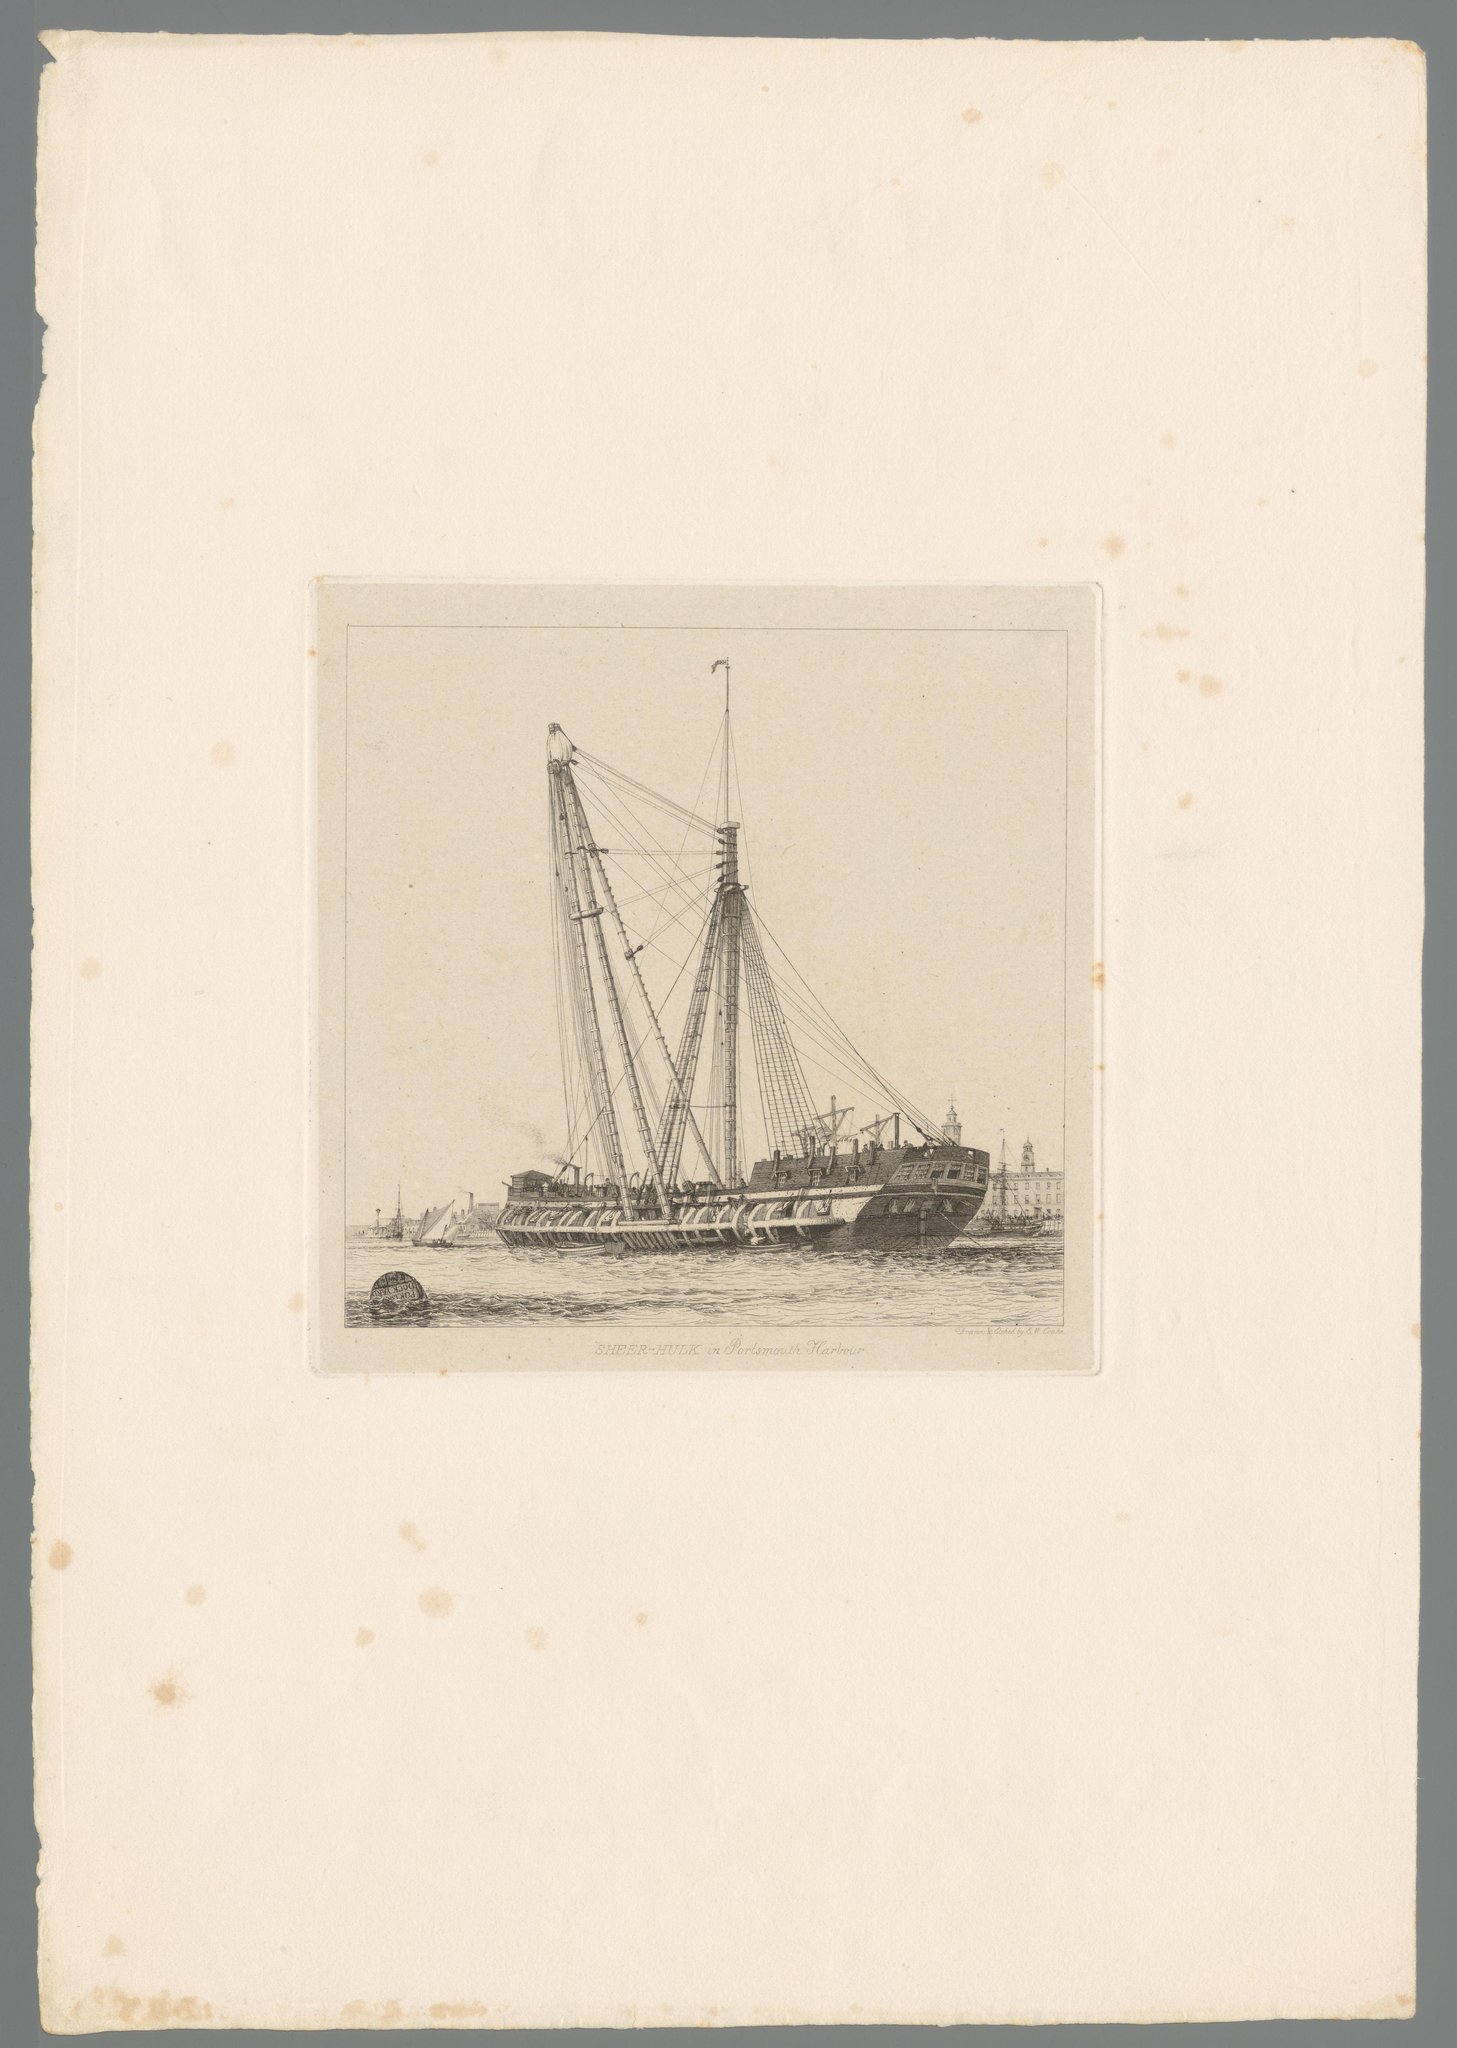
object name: print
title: Sheer-Hulk in Portsmouth Harbour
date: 1828-1829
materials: paper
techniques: etching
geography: london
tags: harbour, ships (in general), portsmouth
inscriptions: collector's mark: Lugt 2165